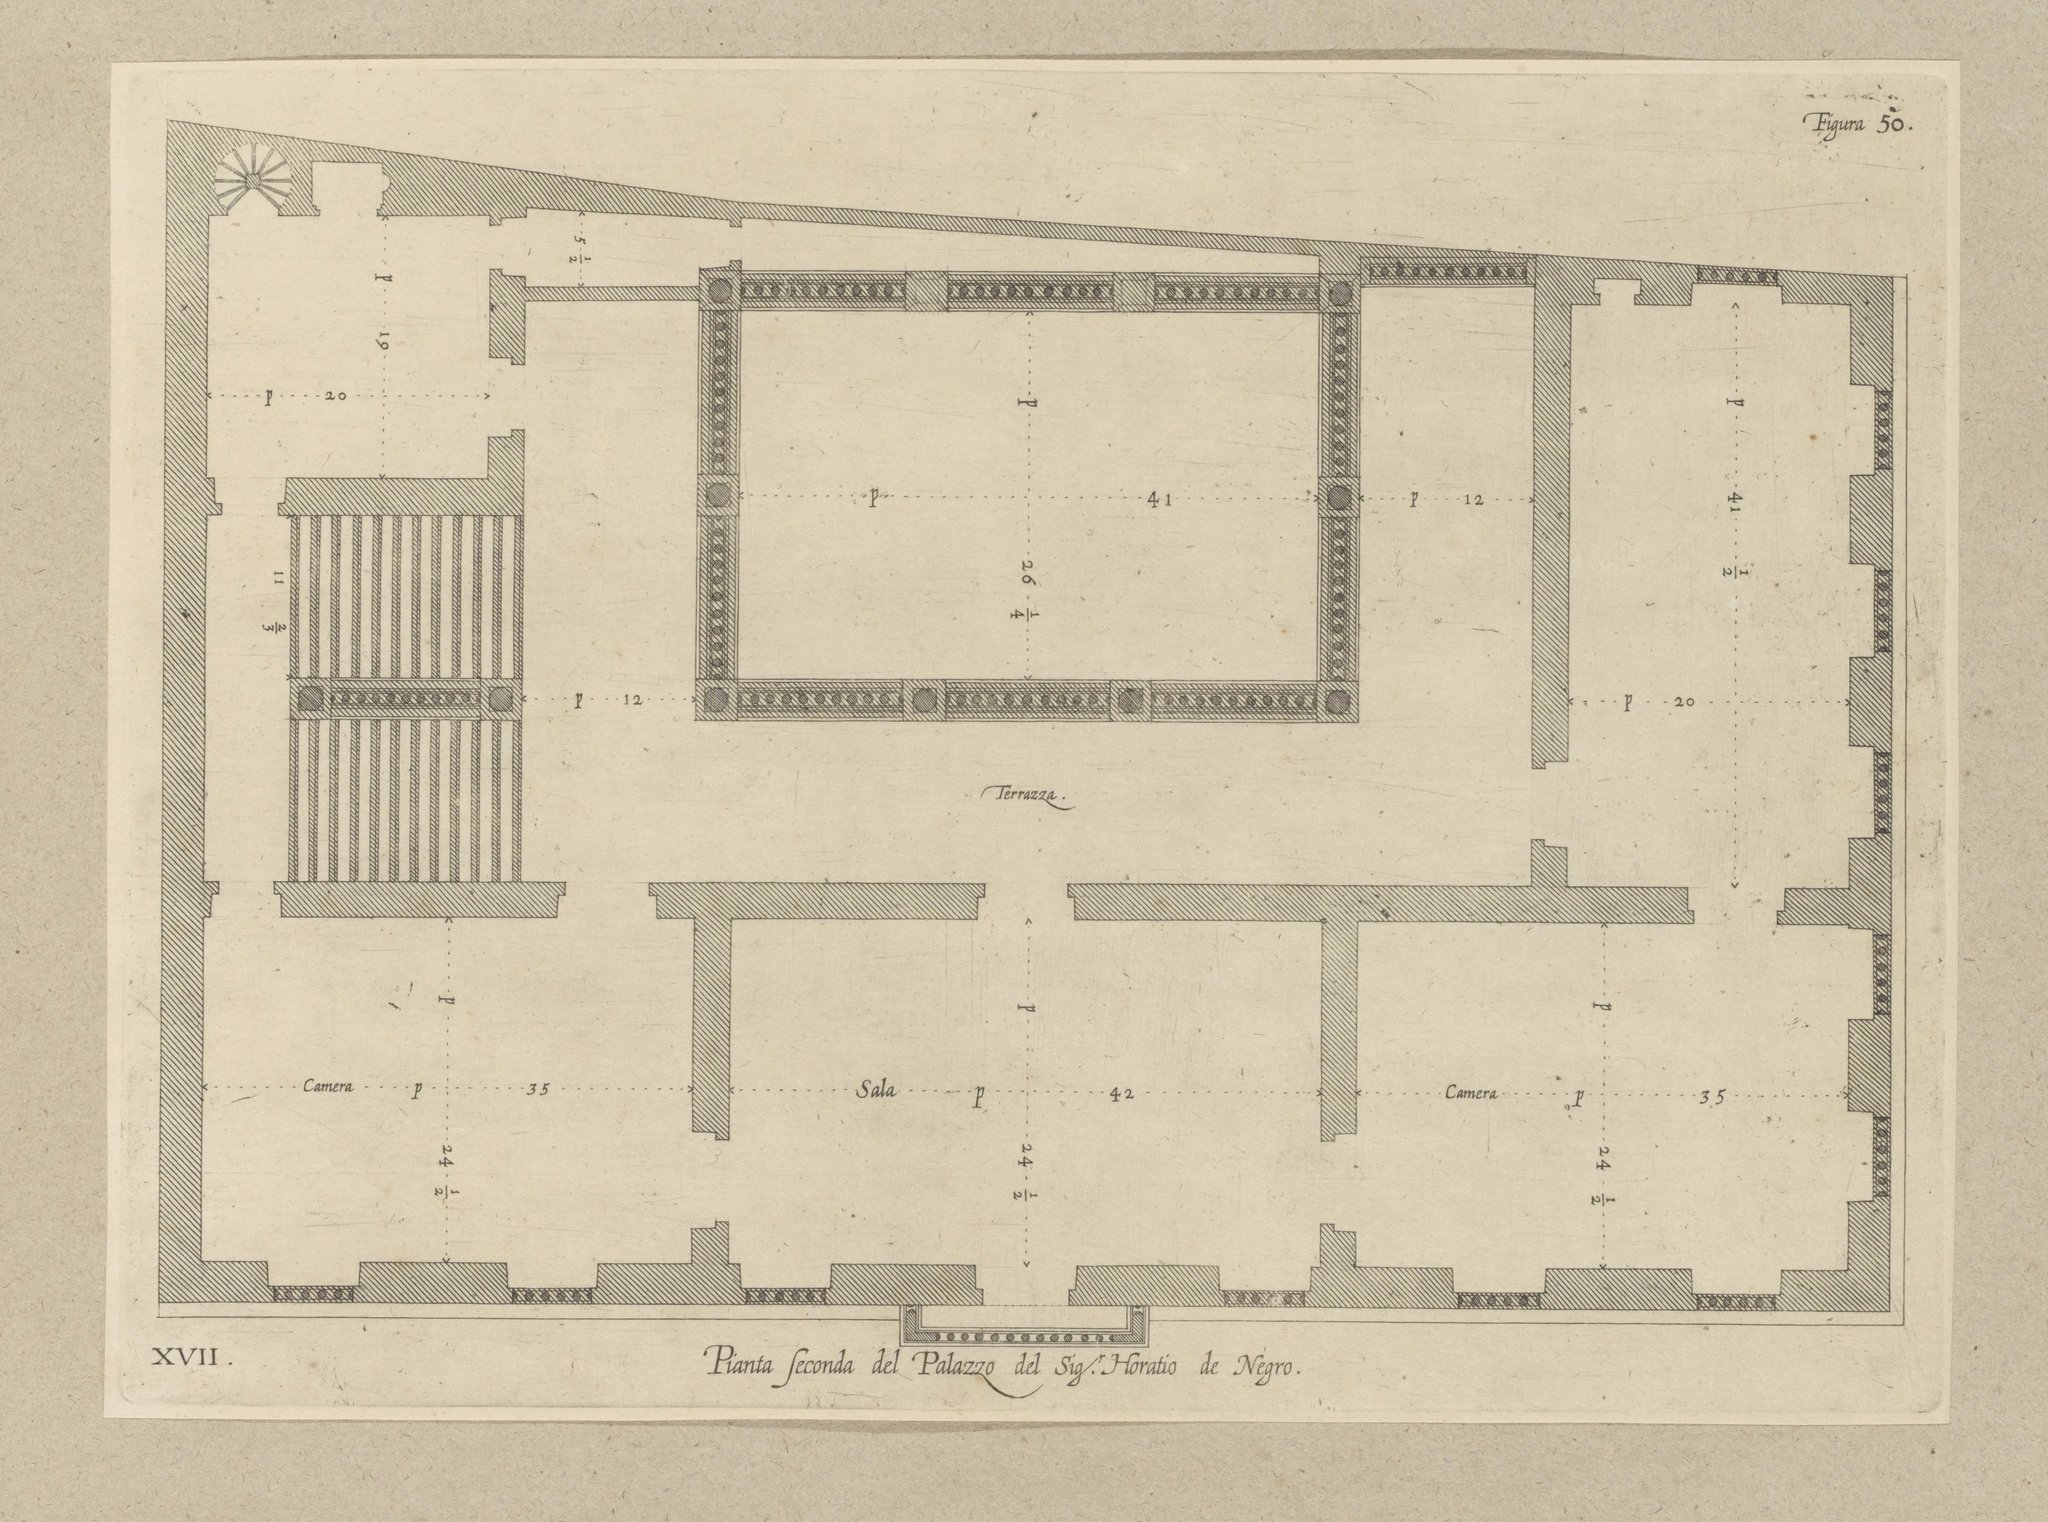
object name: album leaf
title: Pianta seconda del Palazzo del sigr. Horatio de Negro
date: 1622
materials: paper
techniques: engraving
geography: antwerp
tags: hôtel, i.e. small palace in city - aa - civic architecture: inside, plan ~ architecture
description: Deze prent maakt deel uit van een album.